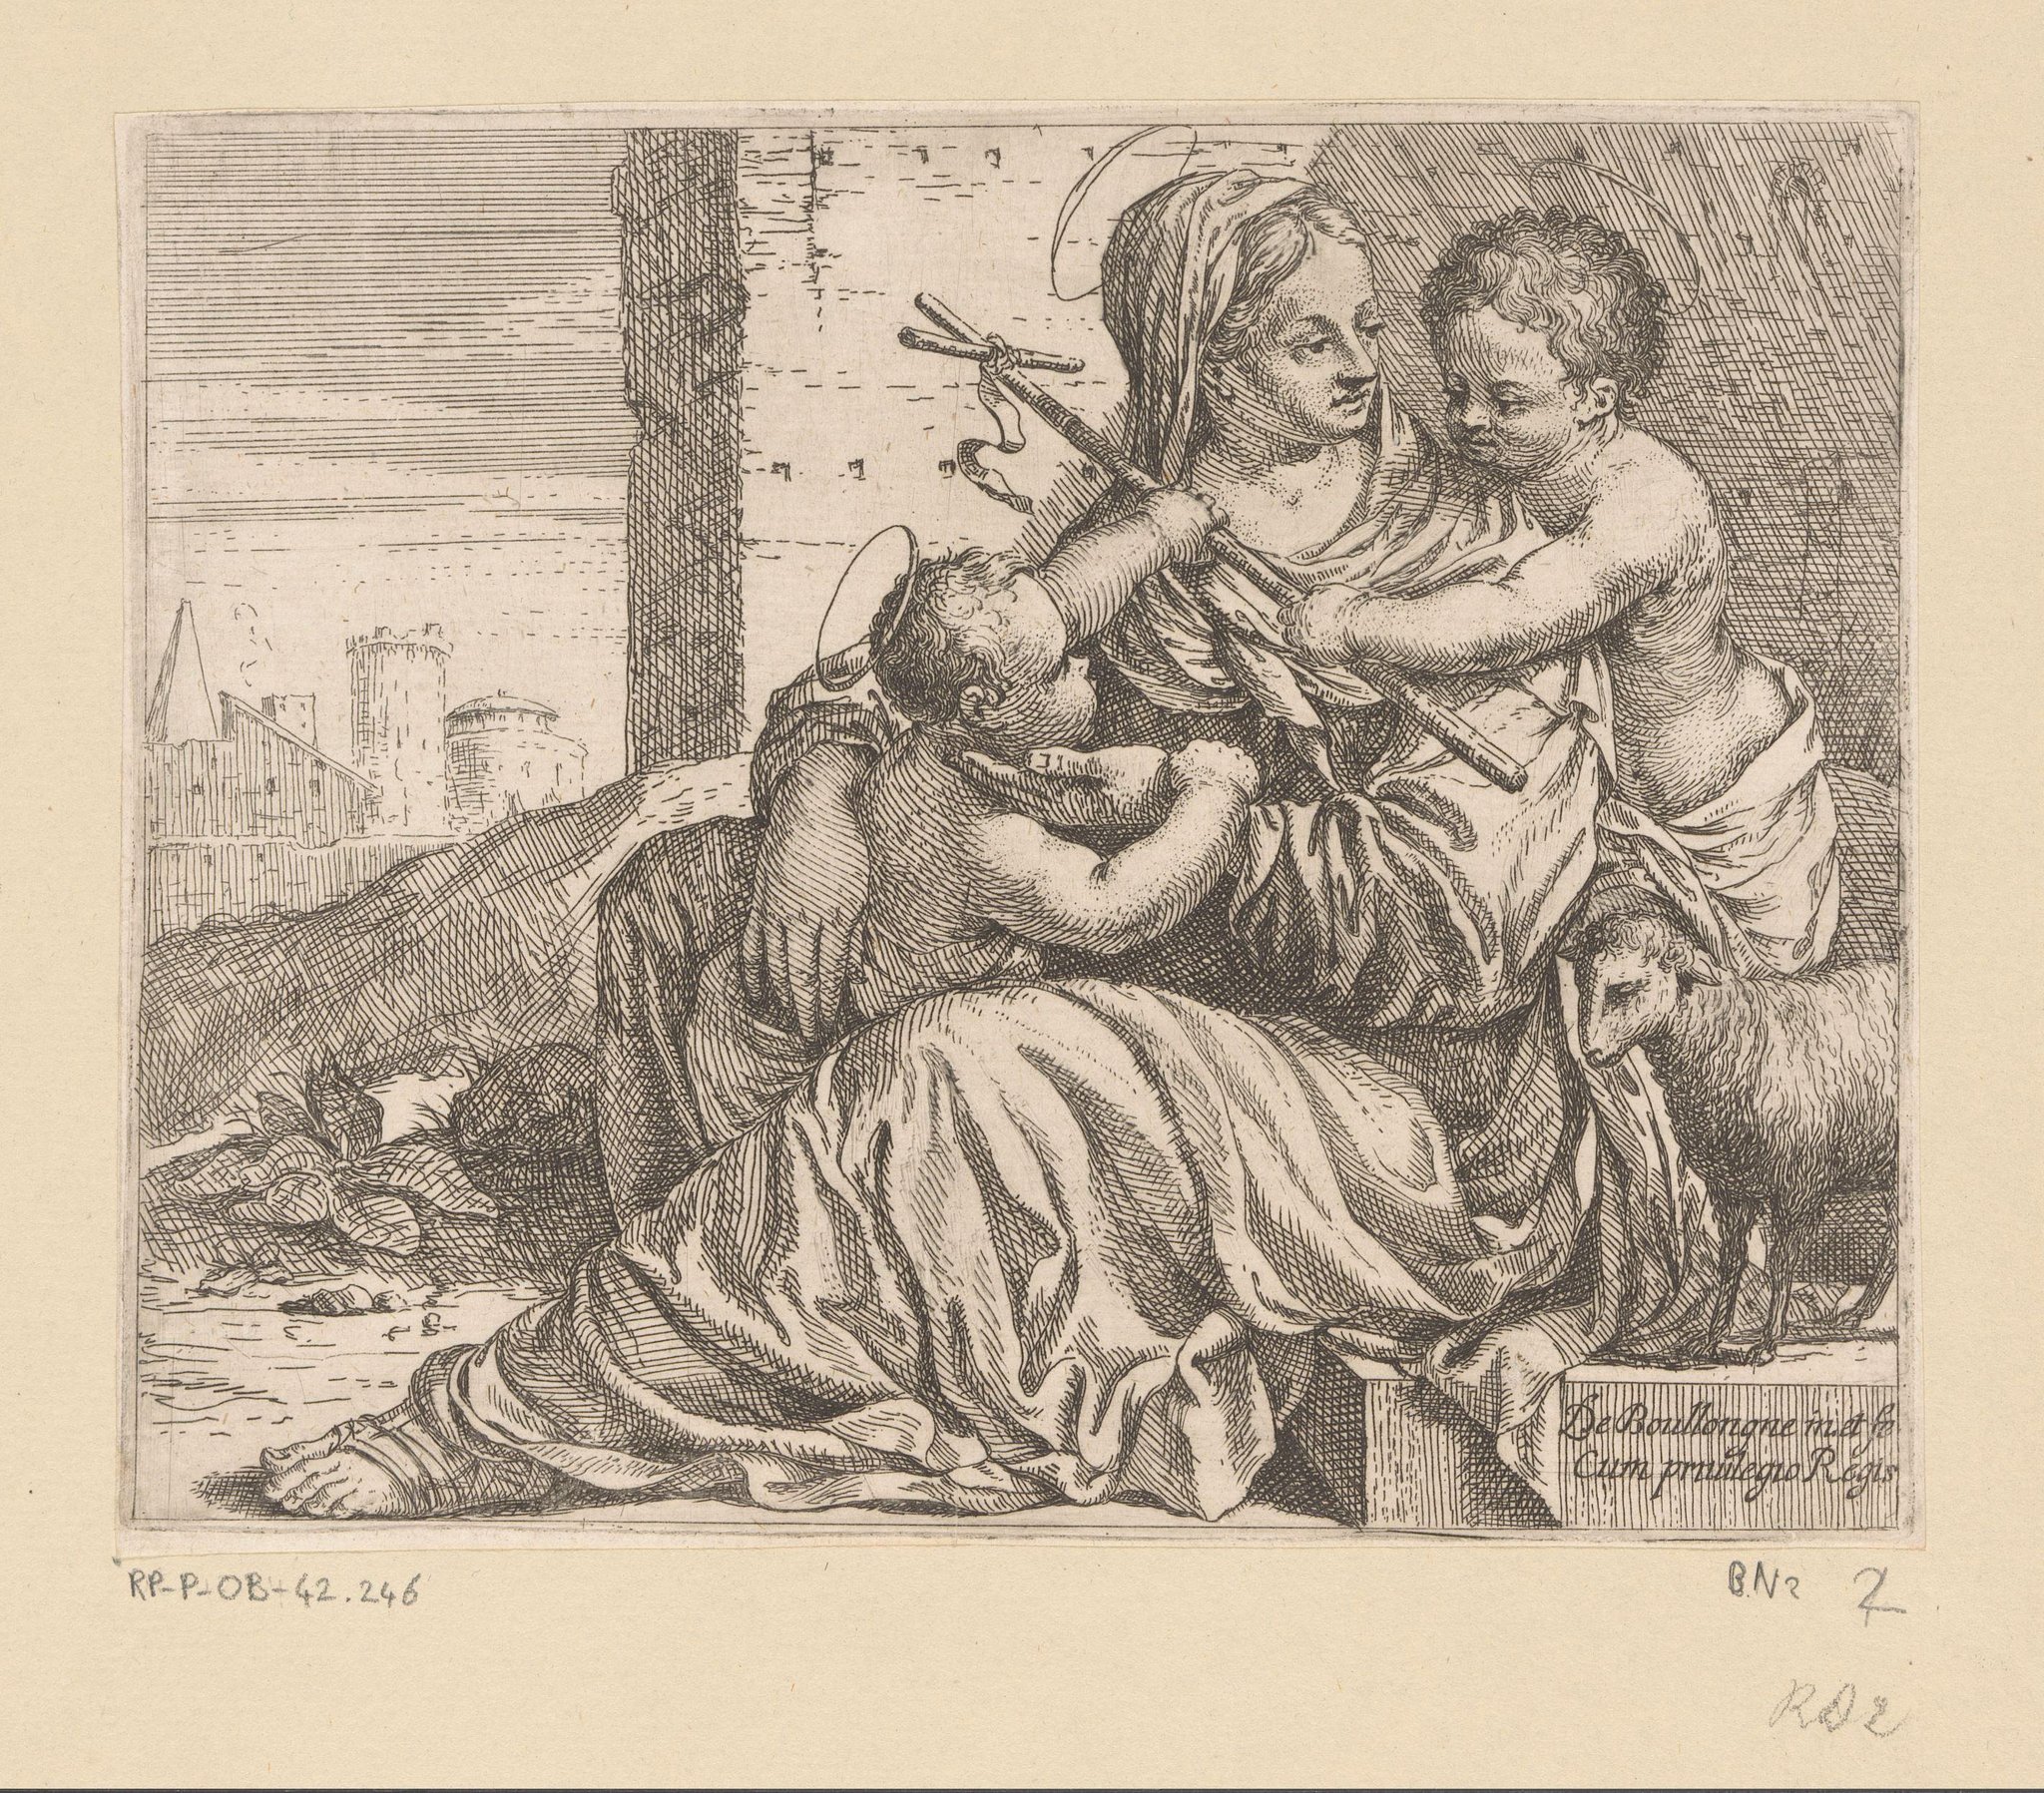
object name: print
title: Maria met Kind en Johannes de Doper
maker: louis de boullogne (i)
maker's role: draughtsman, painter, print maker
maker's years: 1609-1674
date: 1619-1674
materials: paper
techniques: etching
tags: mary and the christ-child with john the baptist (as child)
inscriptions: collector's mark: Lugt 240